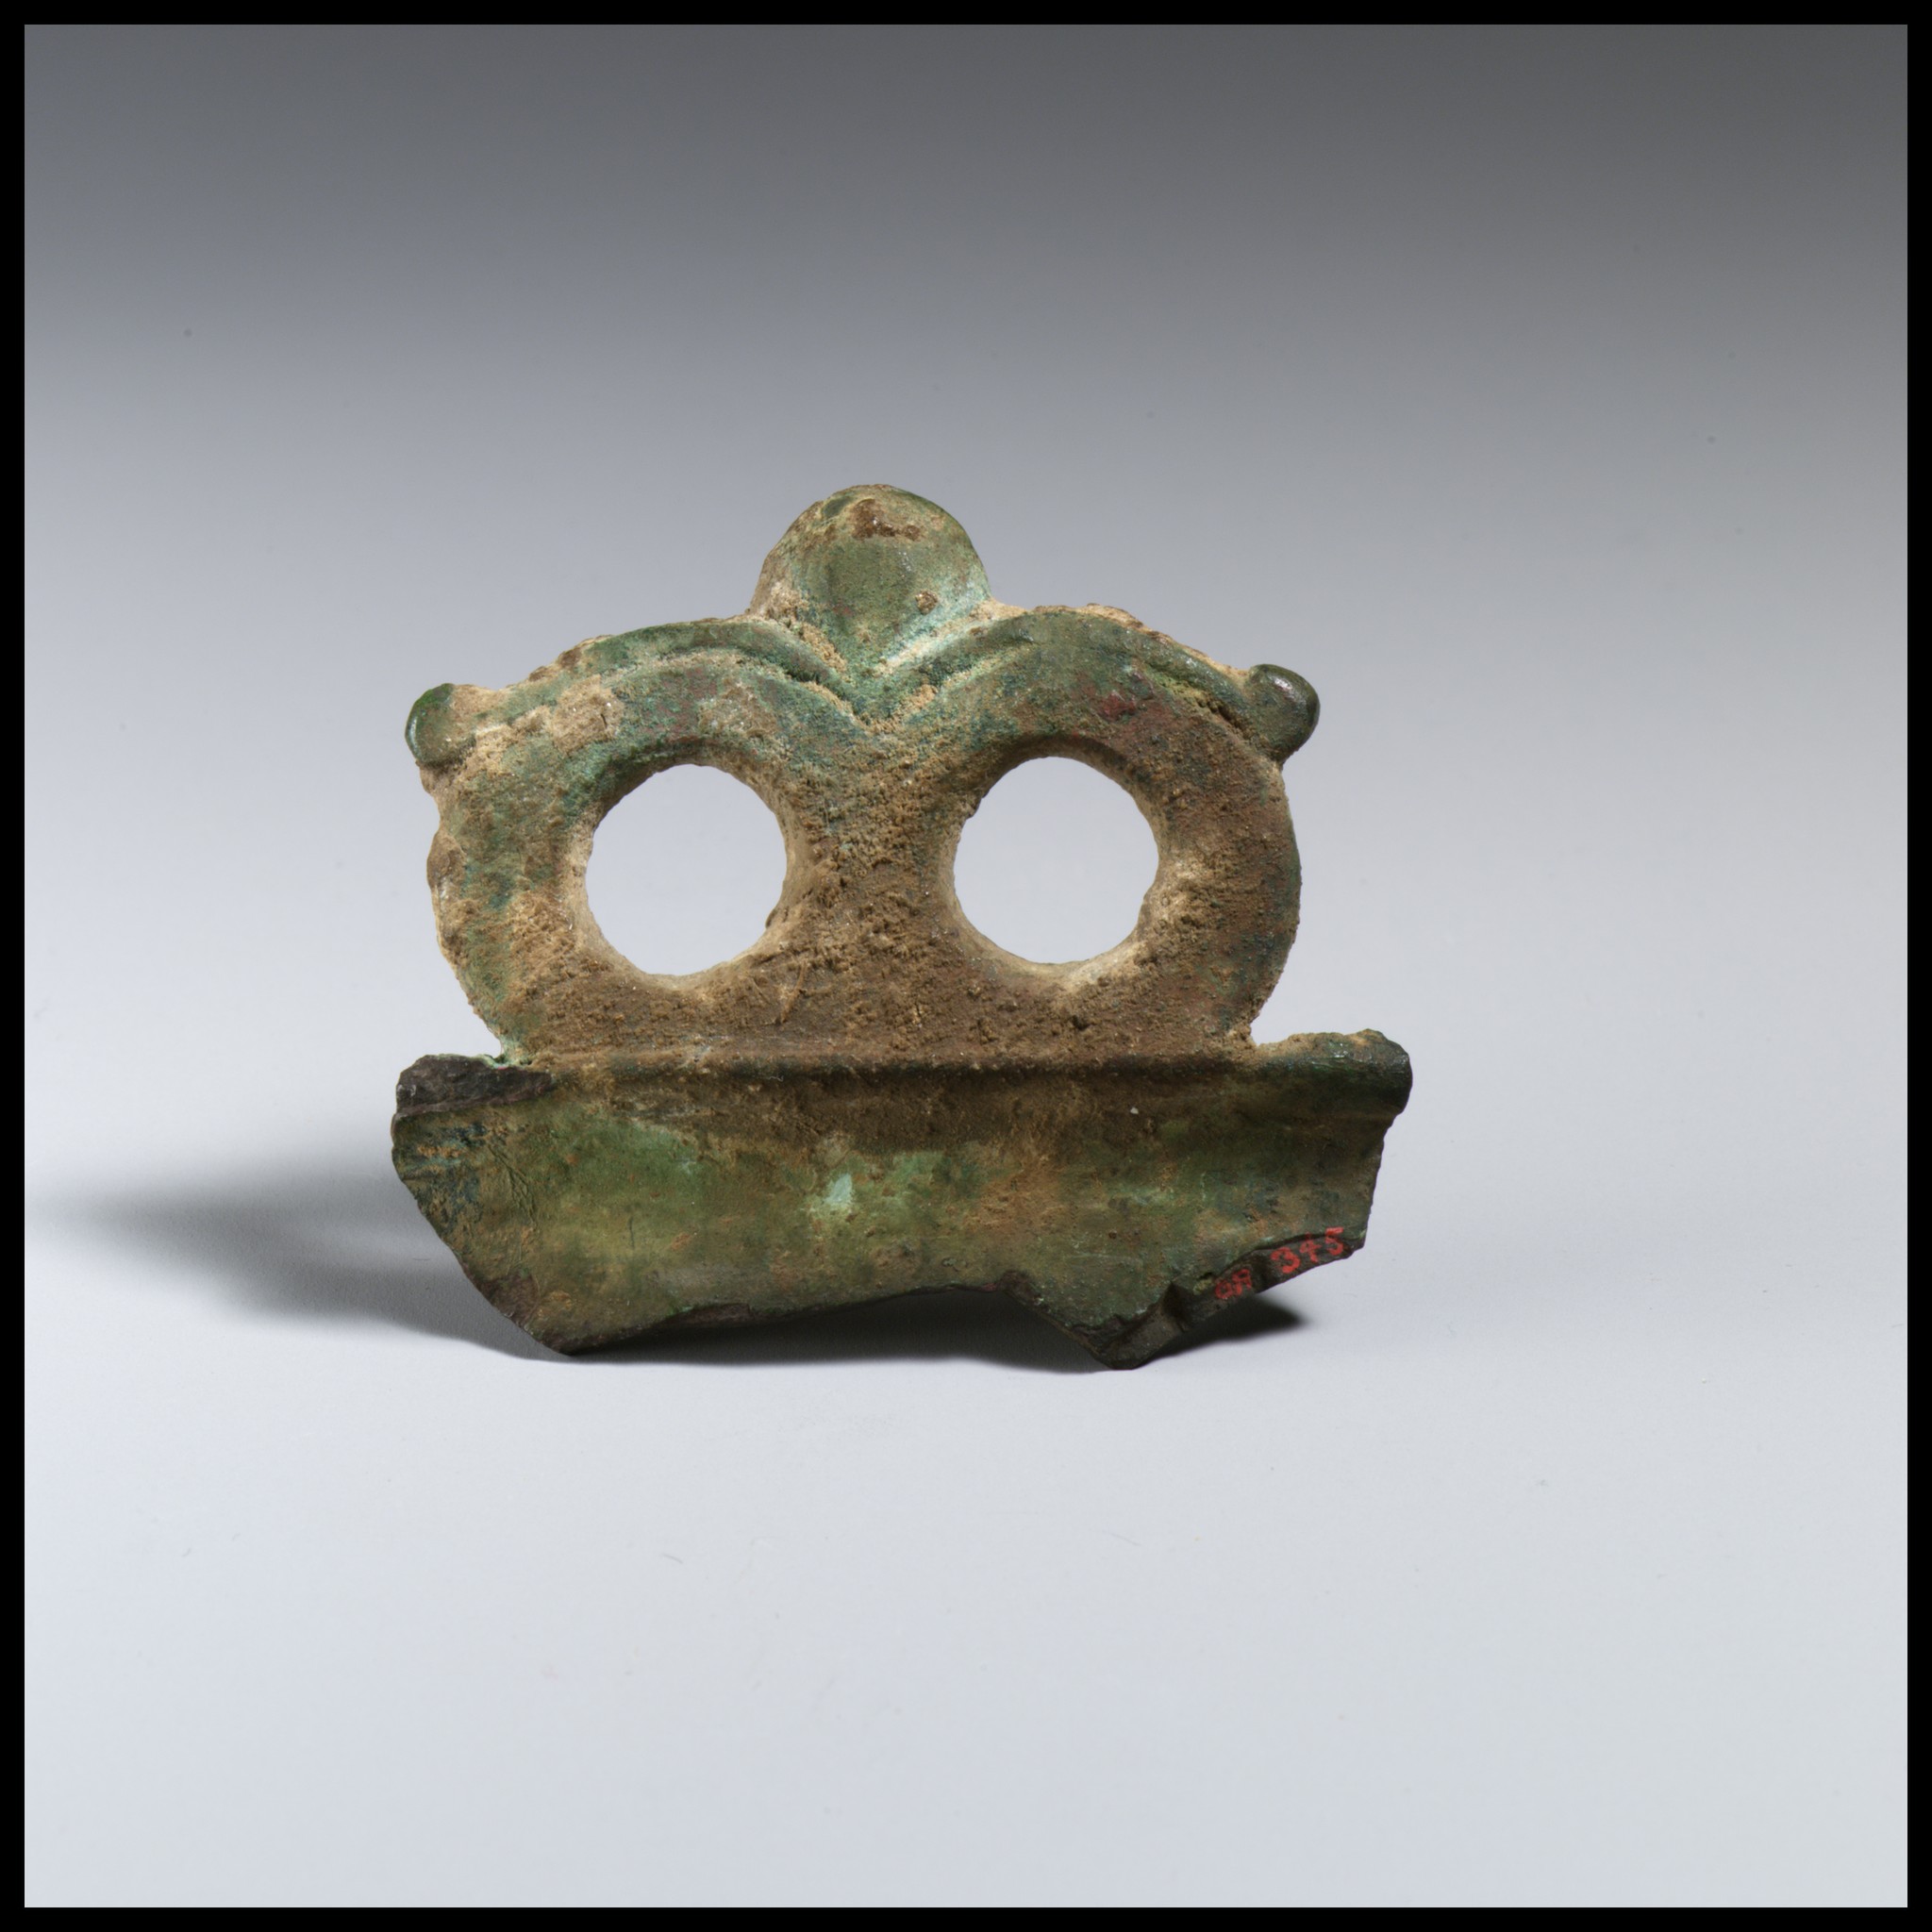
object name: handle attachment for a pail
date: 7000 BCE-330 CE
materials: bronze